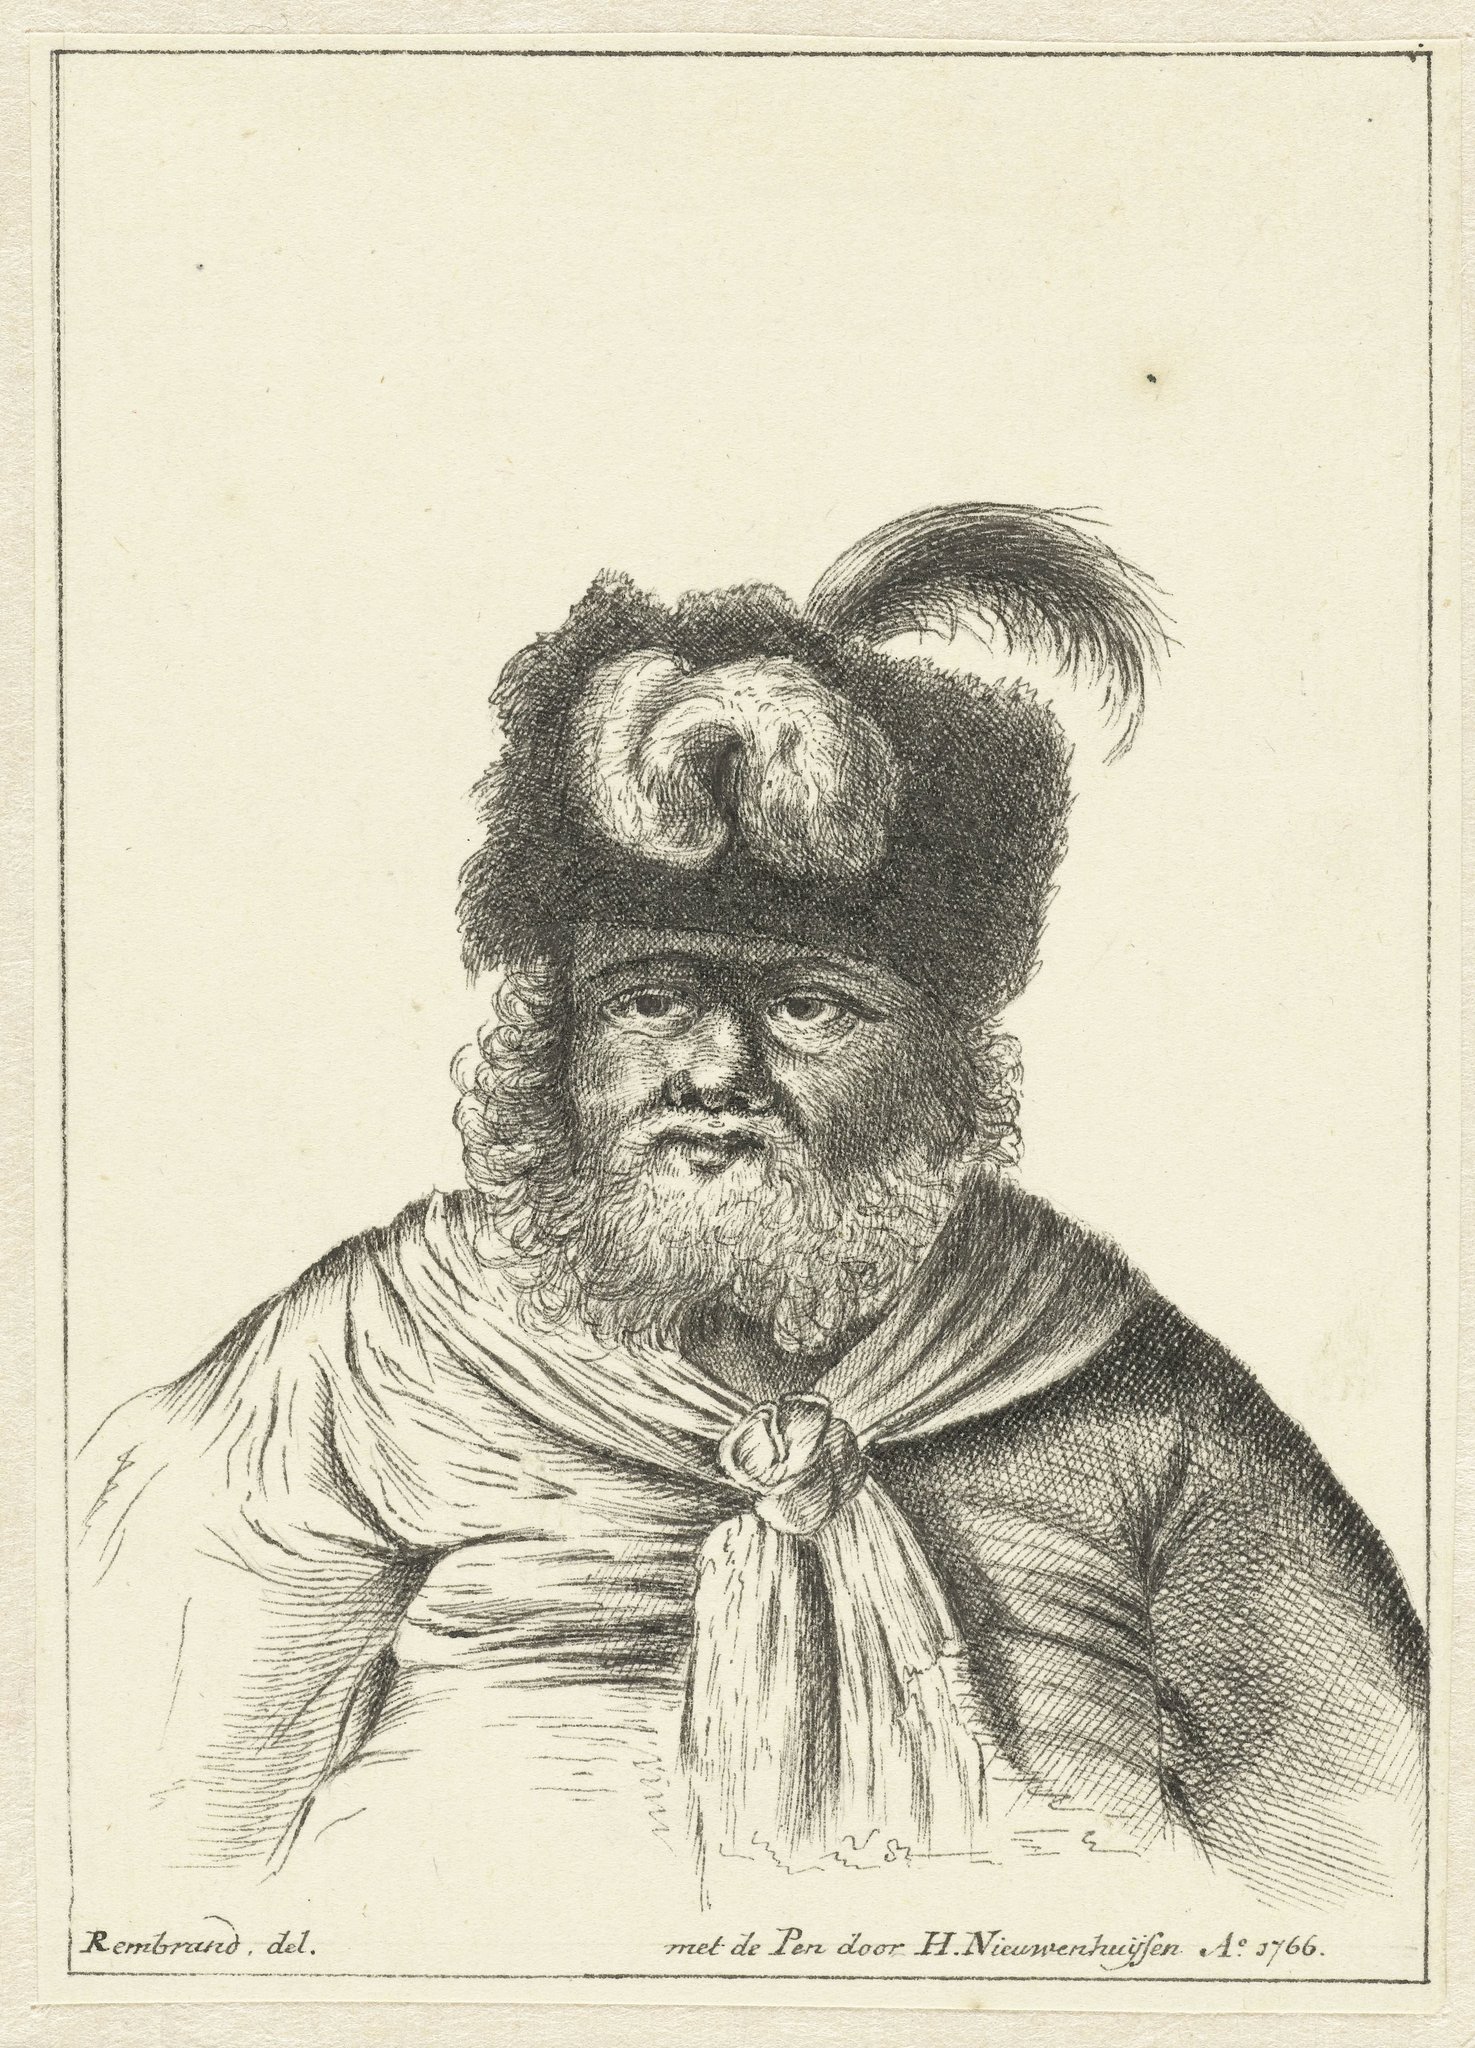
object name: drawing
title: Zittende man met bontmuts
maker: hendrik nieuwenhuysen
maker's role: draughtsman, print maker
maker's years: 1747-1794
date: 1766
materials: ink, paper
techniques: pen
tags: head-gear (with name)